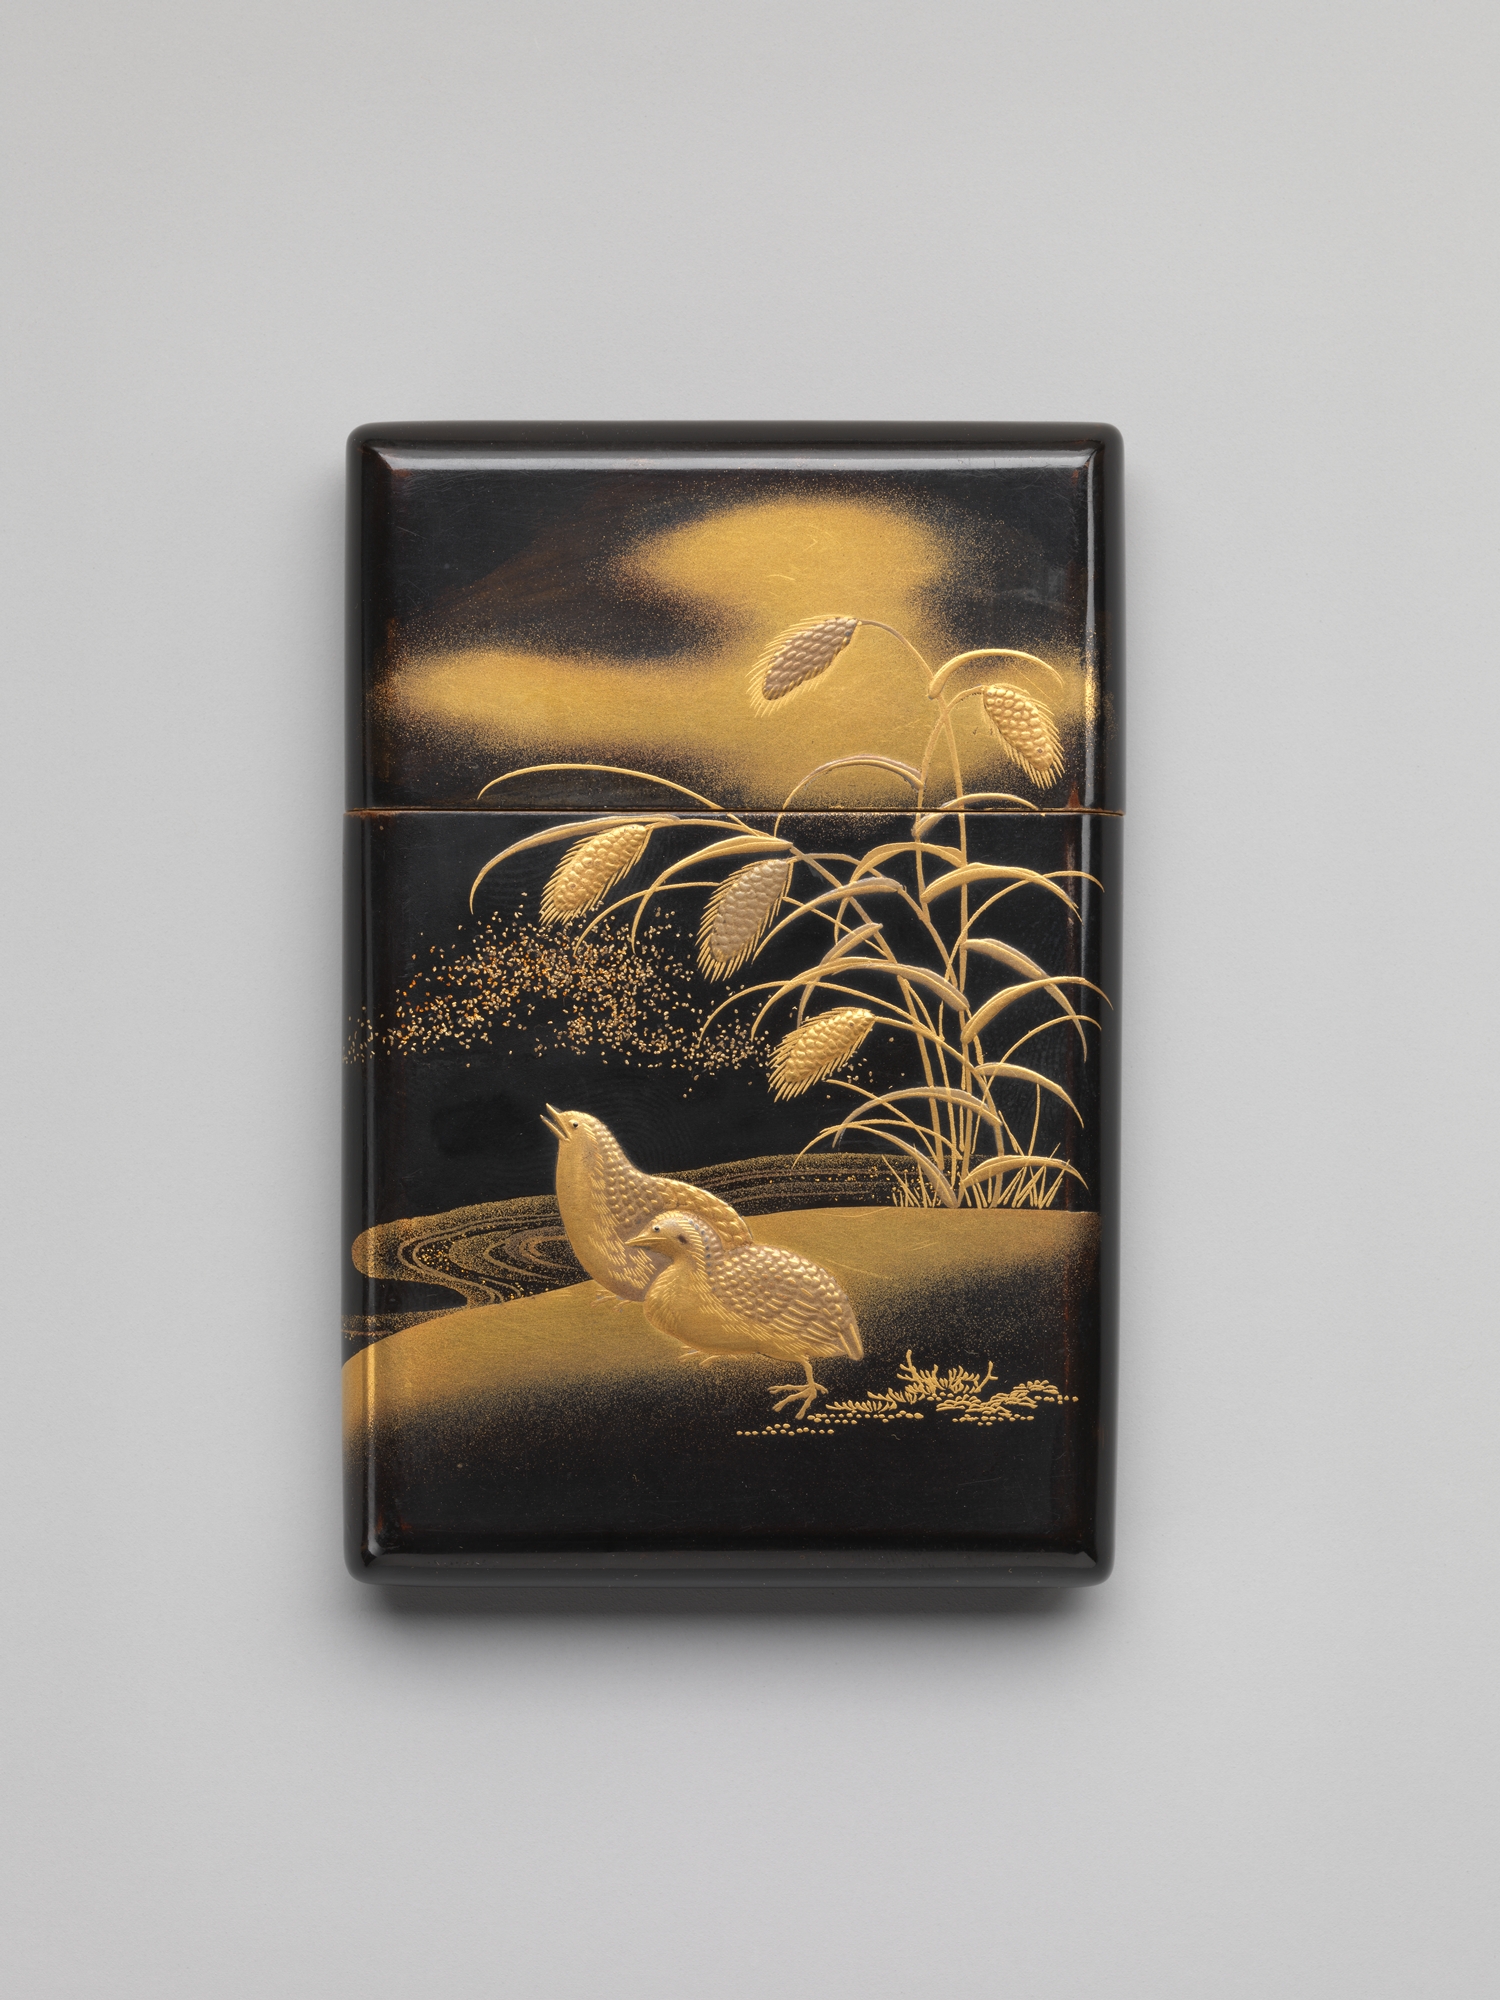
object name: case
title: Case with Quail and Millet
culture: japanese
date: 1834-1866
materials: gold, lacquer, silver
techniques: hiramakie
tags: birds,plants